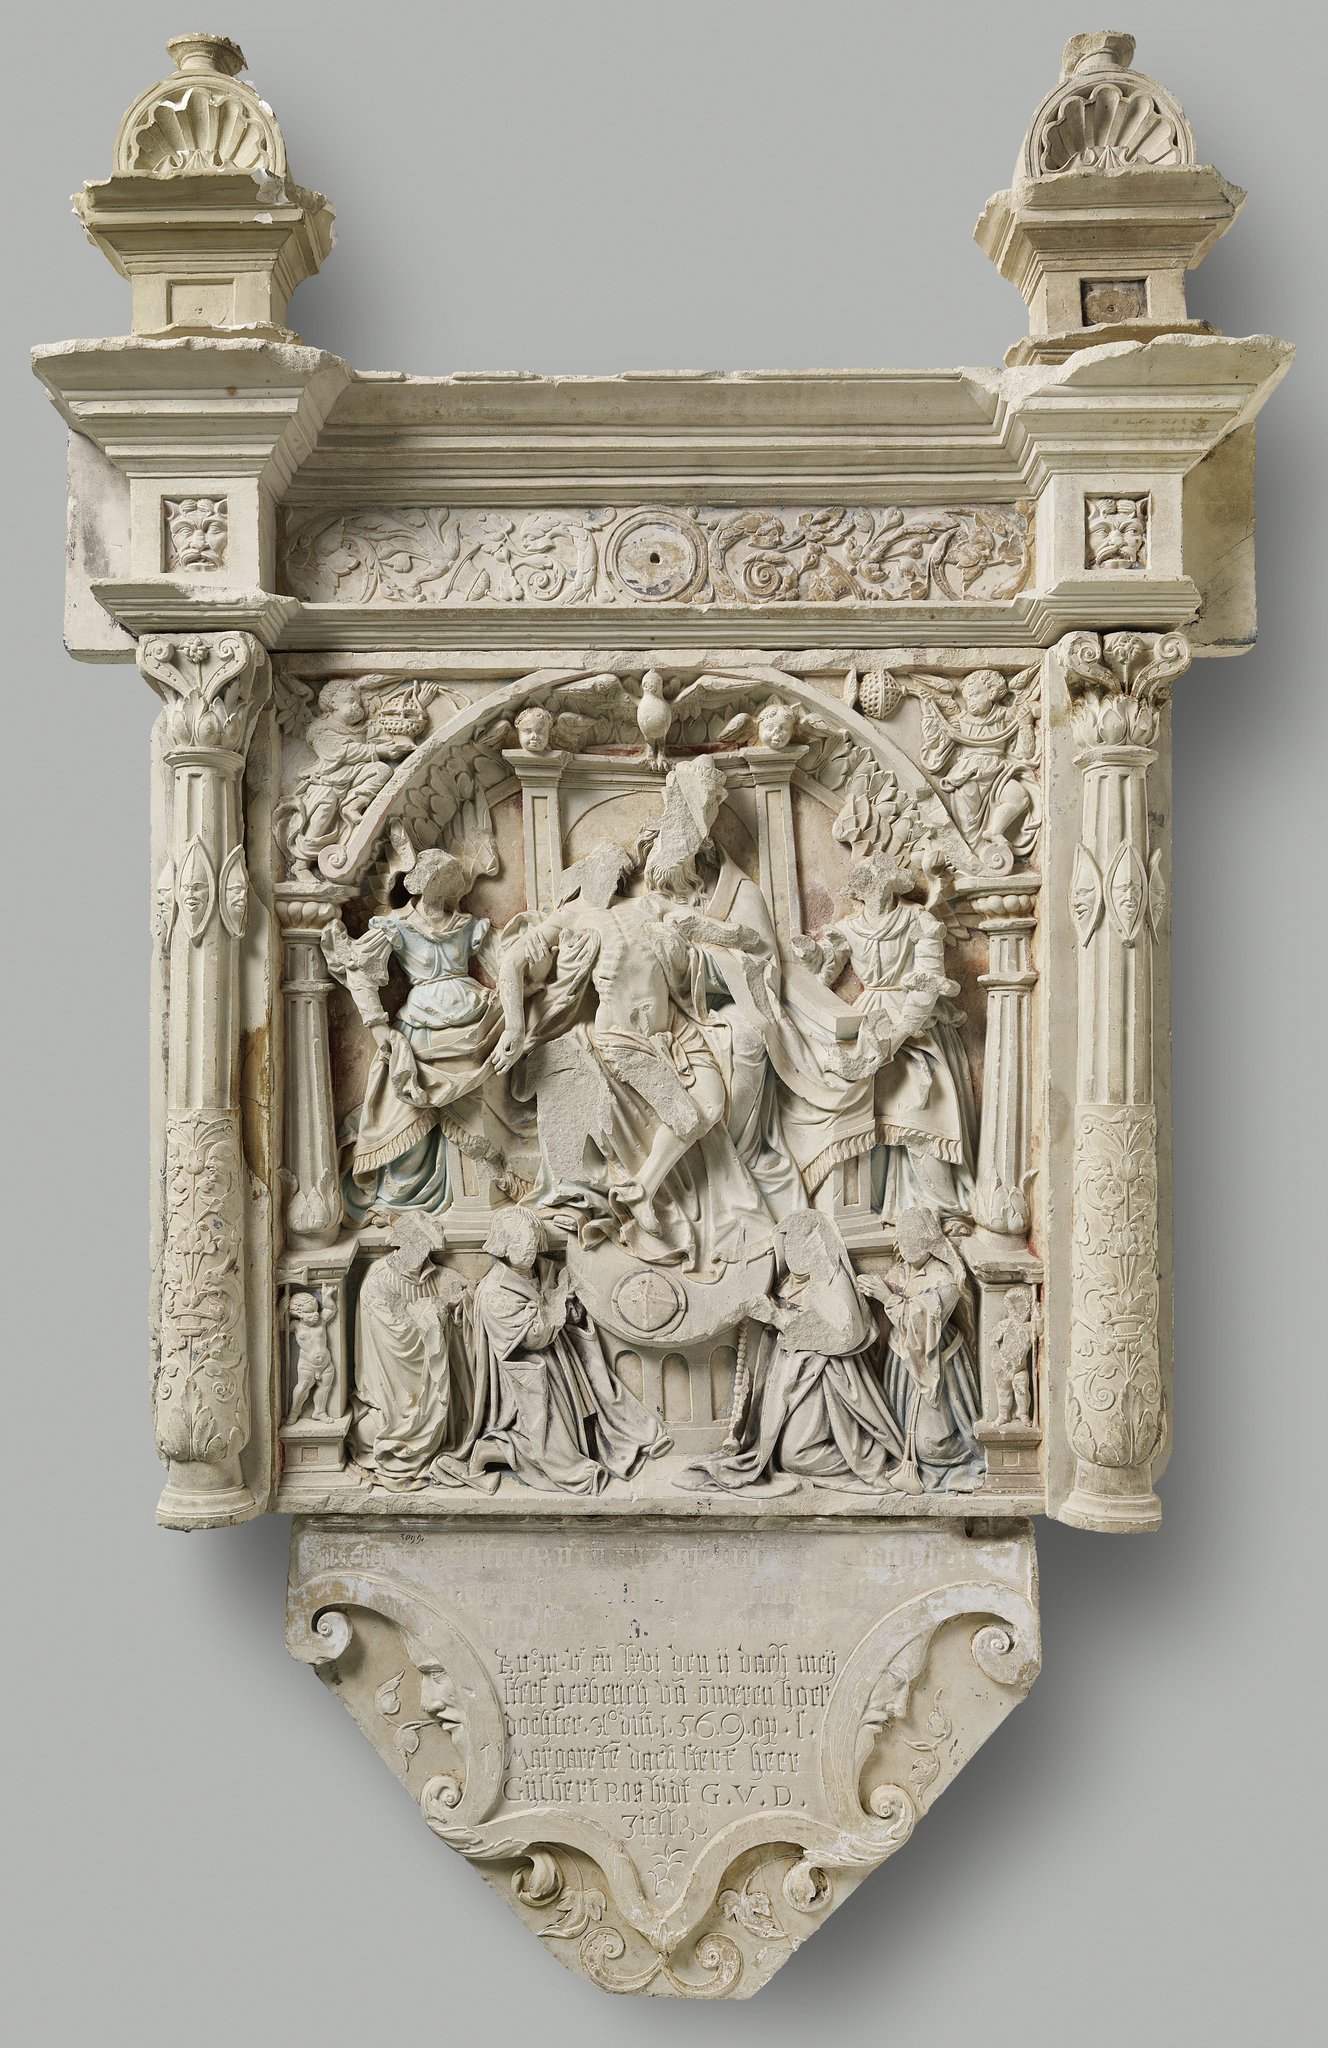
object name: epitaaf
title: Bekroning (links) van epitaaf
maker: arnt van tricht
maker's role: sculptor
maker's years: -1570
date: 1548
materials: gypsum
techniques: polychromy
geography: kalkar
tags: wageningen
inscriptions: inscription: ‘ANo MVc EN LXVI DEN II DACH MEIJ STERF GERBERICH VA OMEREN HOOR DOCHTER / Ao DOMINI 1569 OP S: MARGARETE DACH STERF HEER GIJSBERT ROS Bidt G.V.D. ZIELL’, inscription: ‘INT IAER ONS HERE MVcXLVIII OP SINTE EGIDII DACH STERF DERRICK ROS / Ao DNI VC o STERF NERTWICH SIJN HUYSFROU o SIEL’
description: Onderdeel van epitaaf van de familie Ros uit de Grote Kerk te Wageningen.